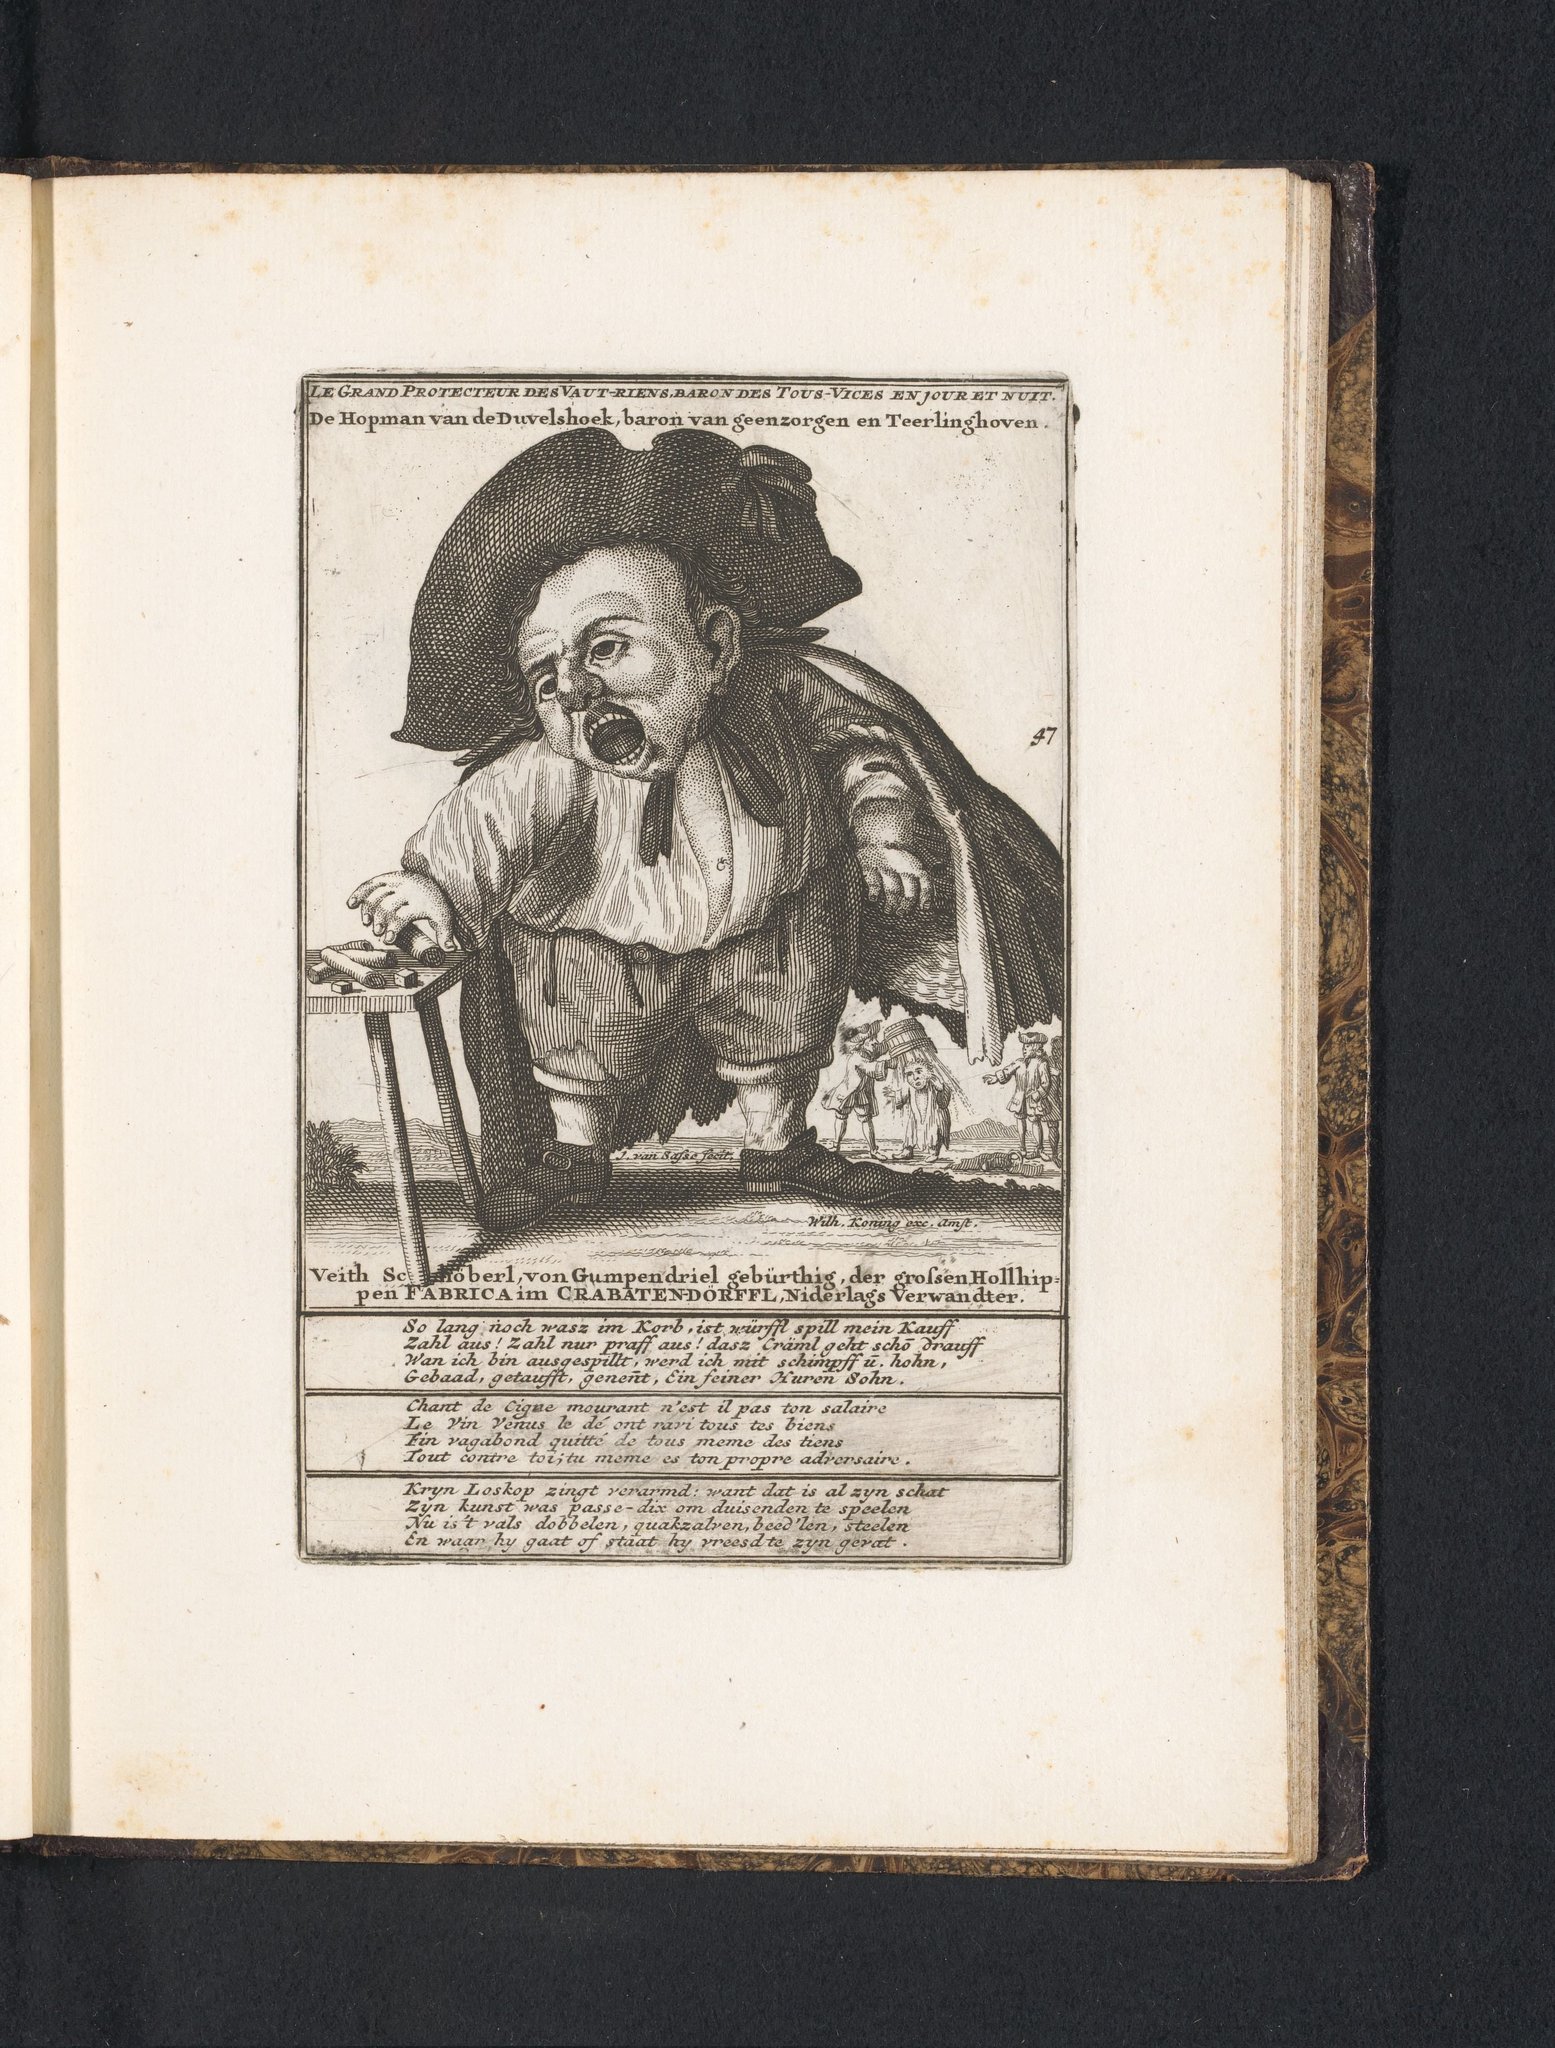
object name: print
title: De dwerg Hopman van Duvelshoek, 1720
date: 1718-1720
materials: paper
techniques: etching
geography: amsterdam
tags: caricatures (human types), little people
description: De kleine mens Hopman van Duvelshoek. In het onderschrift verzen in het Duits, Frans en Nederlands. Genummerd rechts midden: 47. Onderdeel van deel II in de tweede Nederlandse gebonden uitgave uit 1720 (en gerelateerd aan de Windhandel in dat jaar) van een serie karikaturen van kleine mensen, bekend als Het Dwergentooneel.